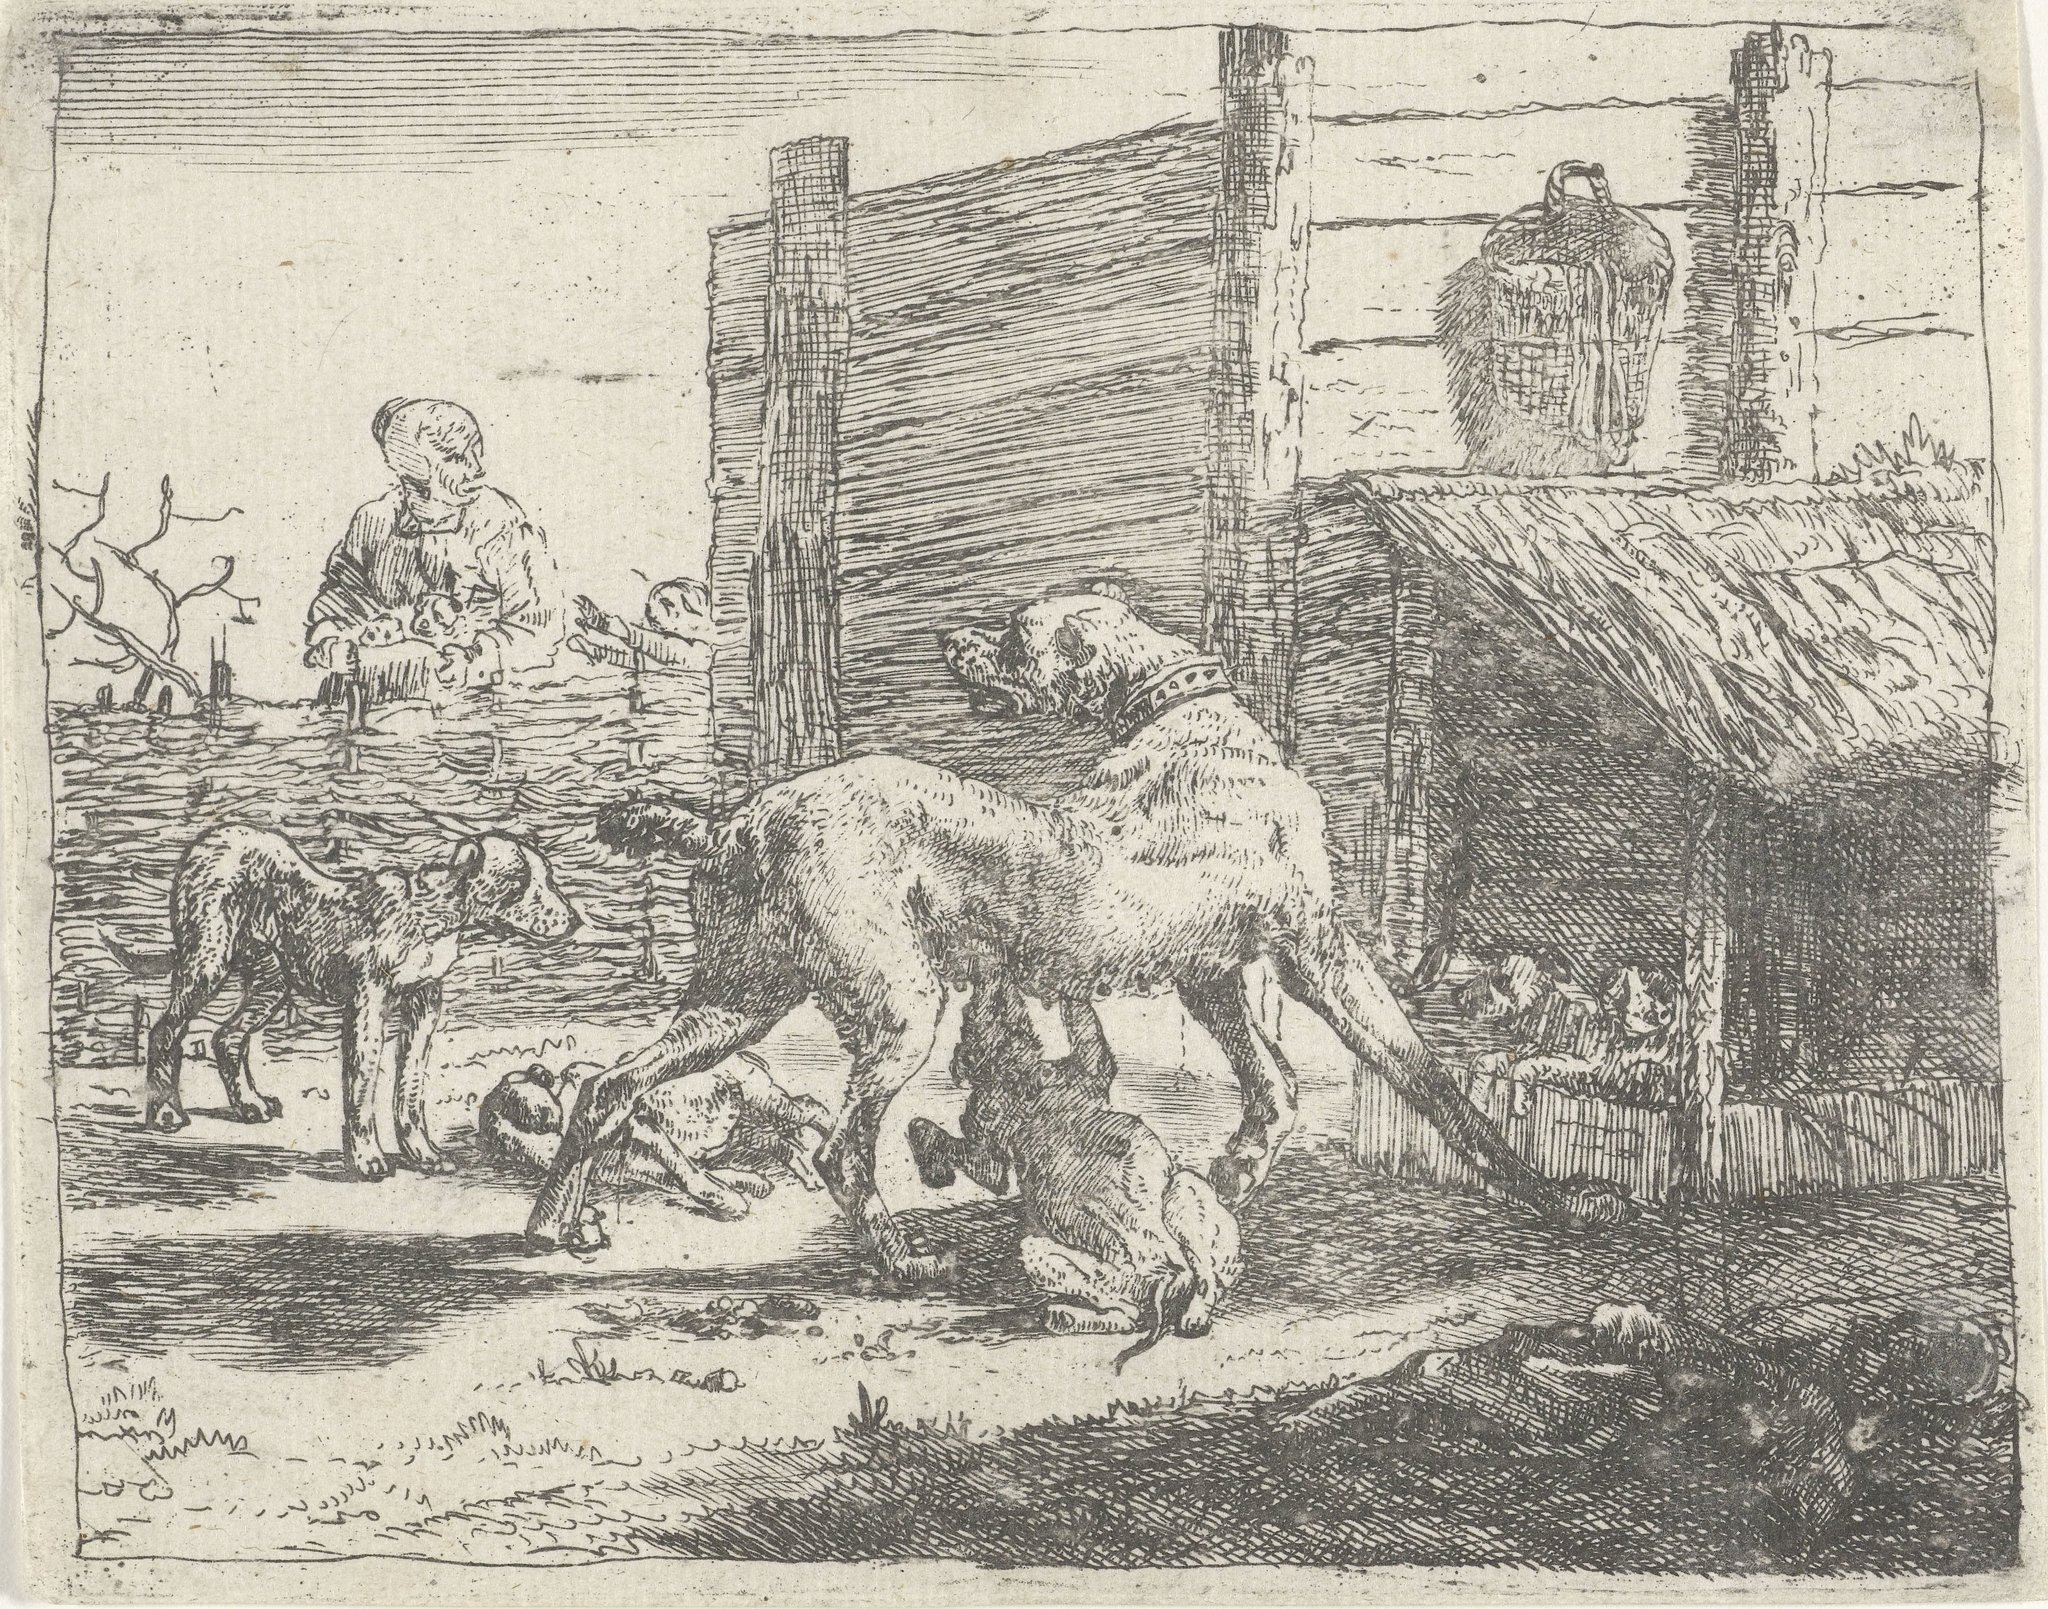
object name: print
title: Teef met puppies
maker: pauwels van hillegaert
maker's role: painter, print maker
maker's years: 1596-1658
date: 1654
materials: paper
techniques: etching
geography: amsterdam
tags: dog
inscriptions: collector's mark: Lugt 240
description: Teef met puppies bij een hondenhok achter een schutting. Vijfde prent van een serie van acht prenten met voorstellingen van honden.